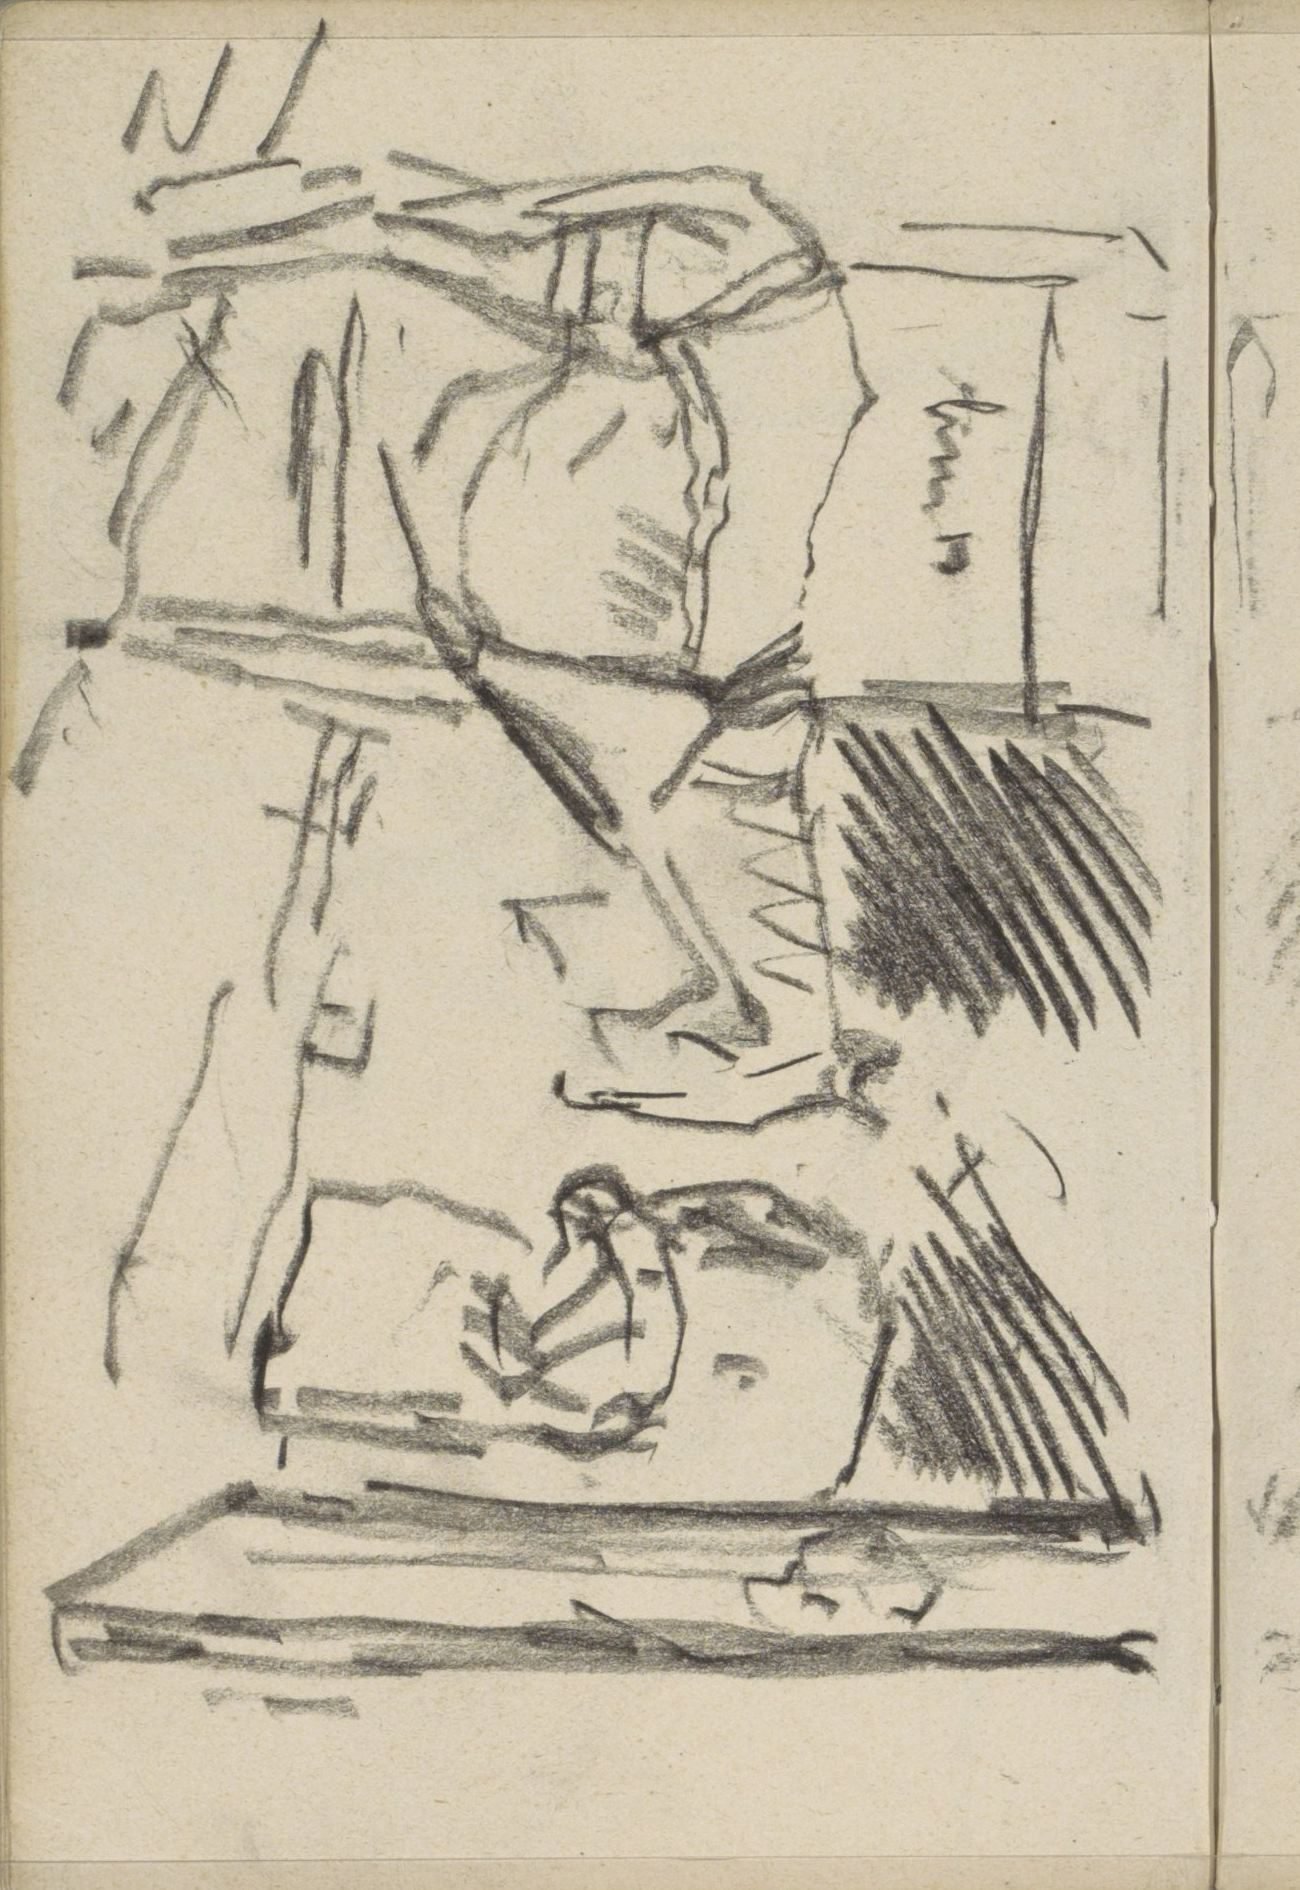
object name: sketchbook leaf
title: Paard met tuig, mogelijk in een stal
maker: george hendrik breitner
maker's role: draughtsman, painter, print maker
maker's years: 1857-1923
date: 1914-1923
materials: chalk, paper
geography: north holland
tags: horse, stall, stable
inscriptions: inscription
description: Paard met tuig, mogelijk in een stal. Pagina 69 uit een schetsboek met 43 bladen vervaardigd te Amsterdam.